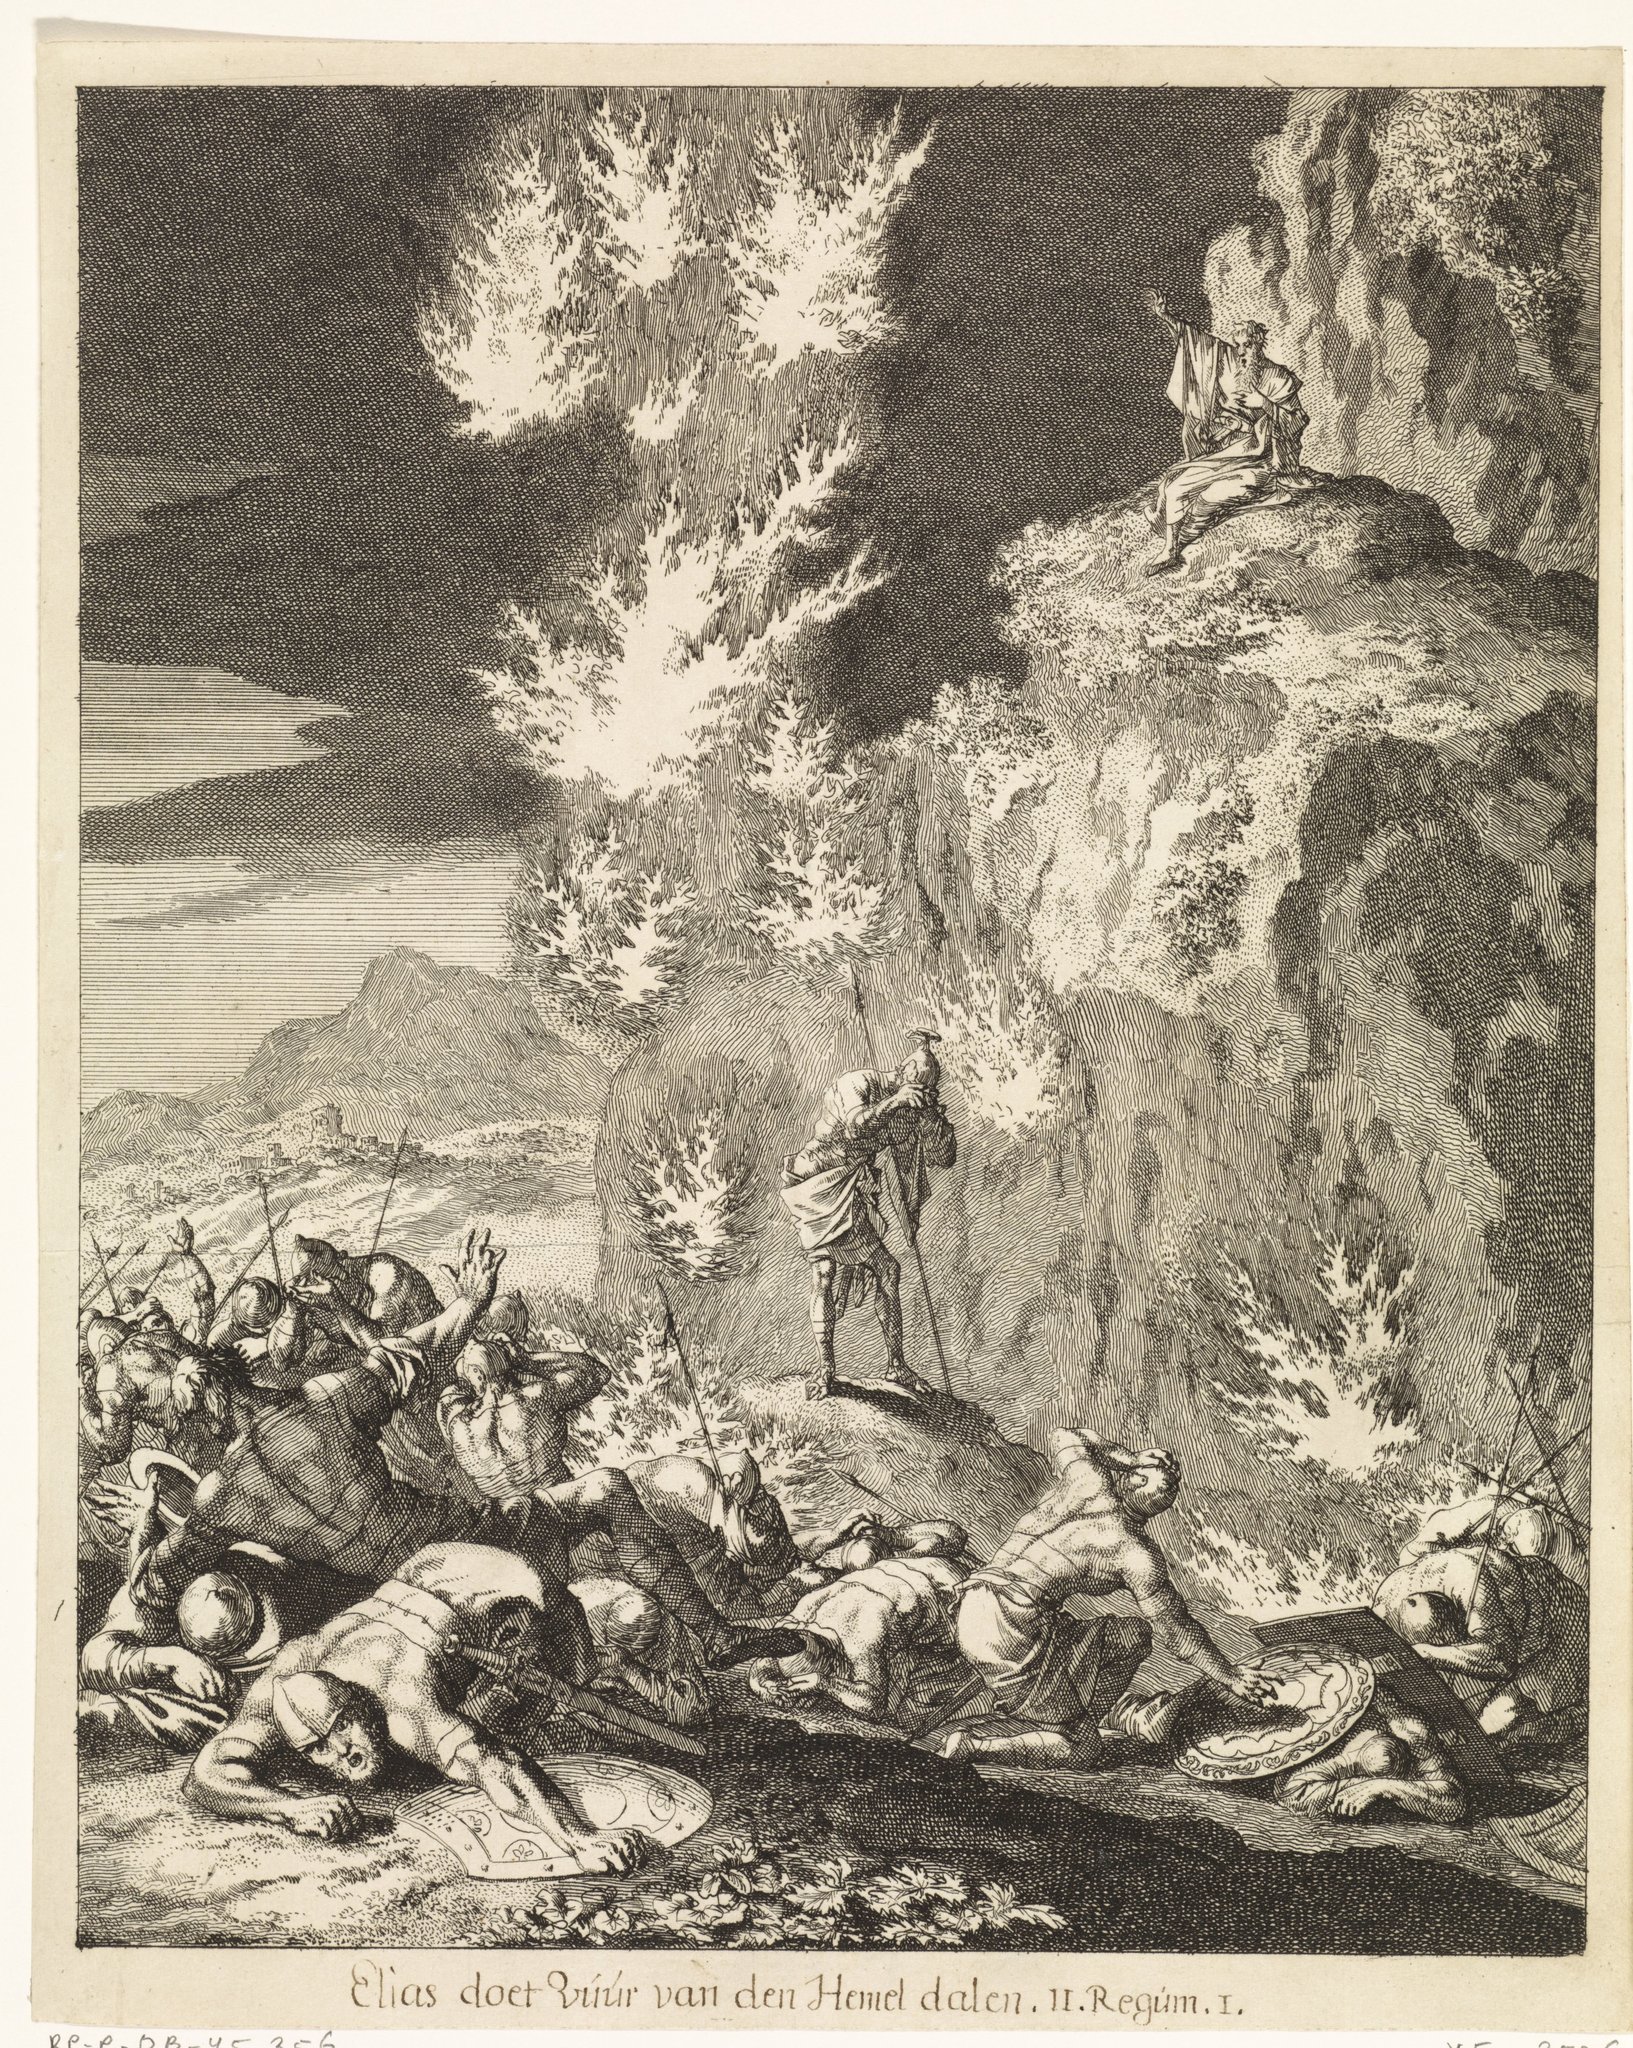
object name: print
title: De door koning Ahazia gezonden officier wordt samen met vijftig soldaten door het vuur verteerd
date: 1708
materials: paper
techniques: etching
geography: amsterdam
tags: when they reach elijah, fire comes down and kills the officer and his men; their replacement is stricken also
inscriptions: collector's mark: Lugt 2228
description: Proefdruk van een prent welke is opgenomen als illustratie in: Historiae Celebriores Veteris Testamenti. Christoph Weigel, 1708.